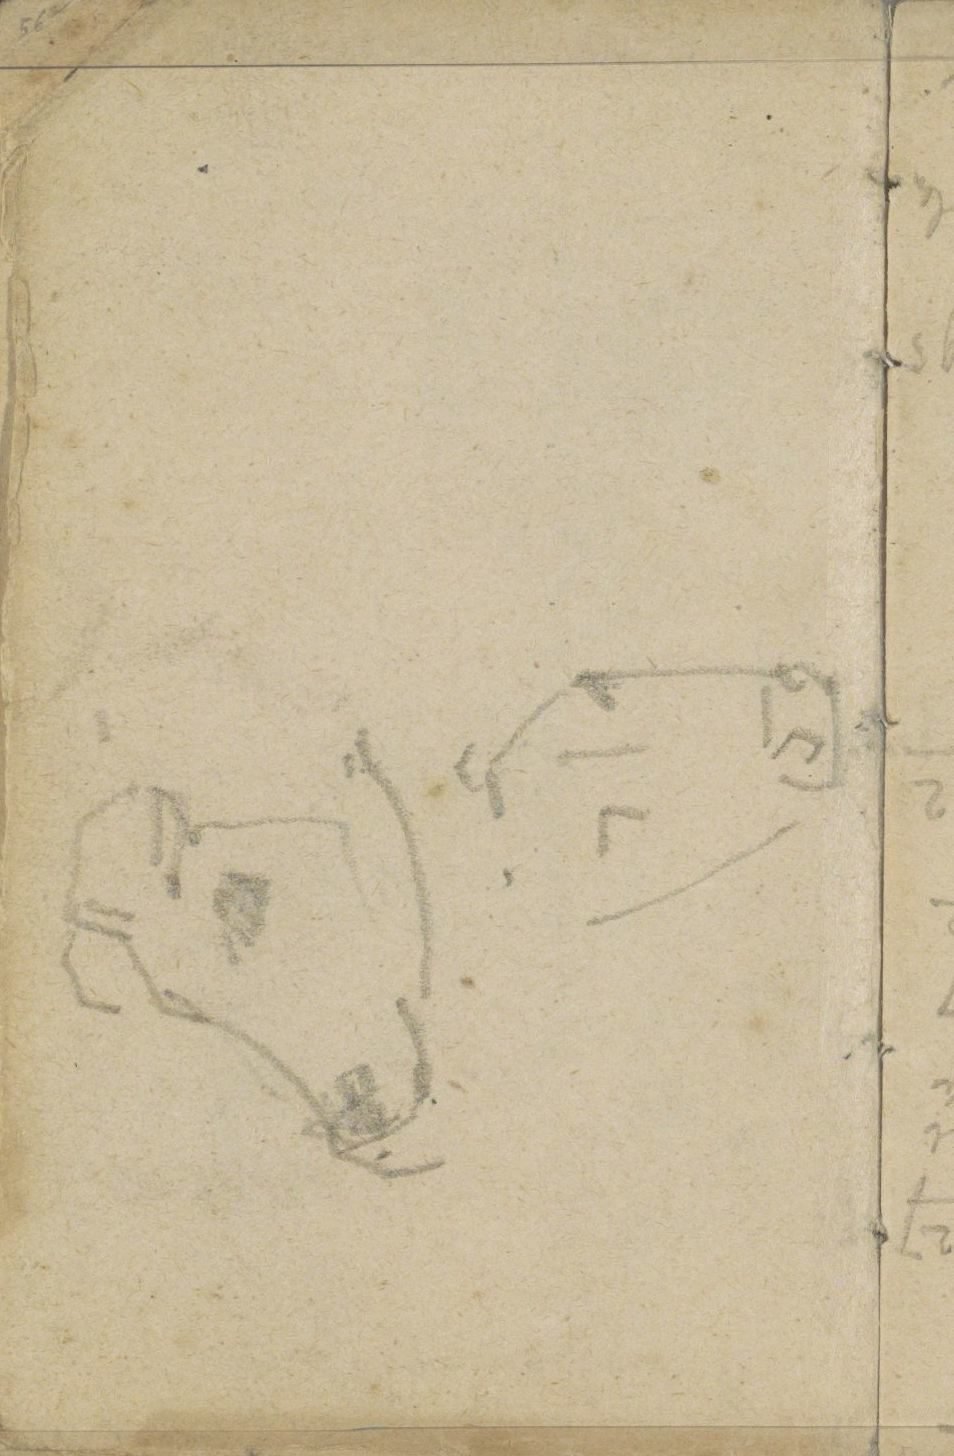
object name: sketchbook leaf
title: Studieblad met varkenskoppen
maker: george hendrik breitner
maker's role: draughtsman, painter, print maker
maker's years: 1857-1923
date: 1881-1883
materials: paper, pencil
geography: south holland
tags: pig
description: Studieblad met varkenskoppen. Pagina 56 uit een schetsboek met 43 bladen.